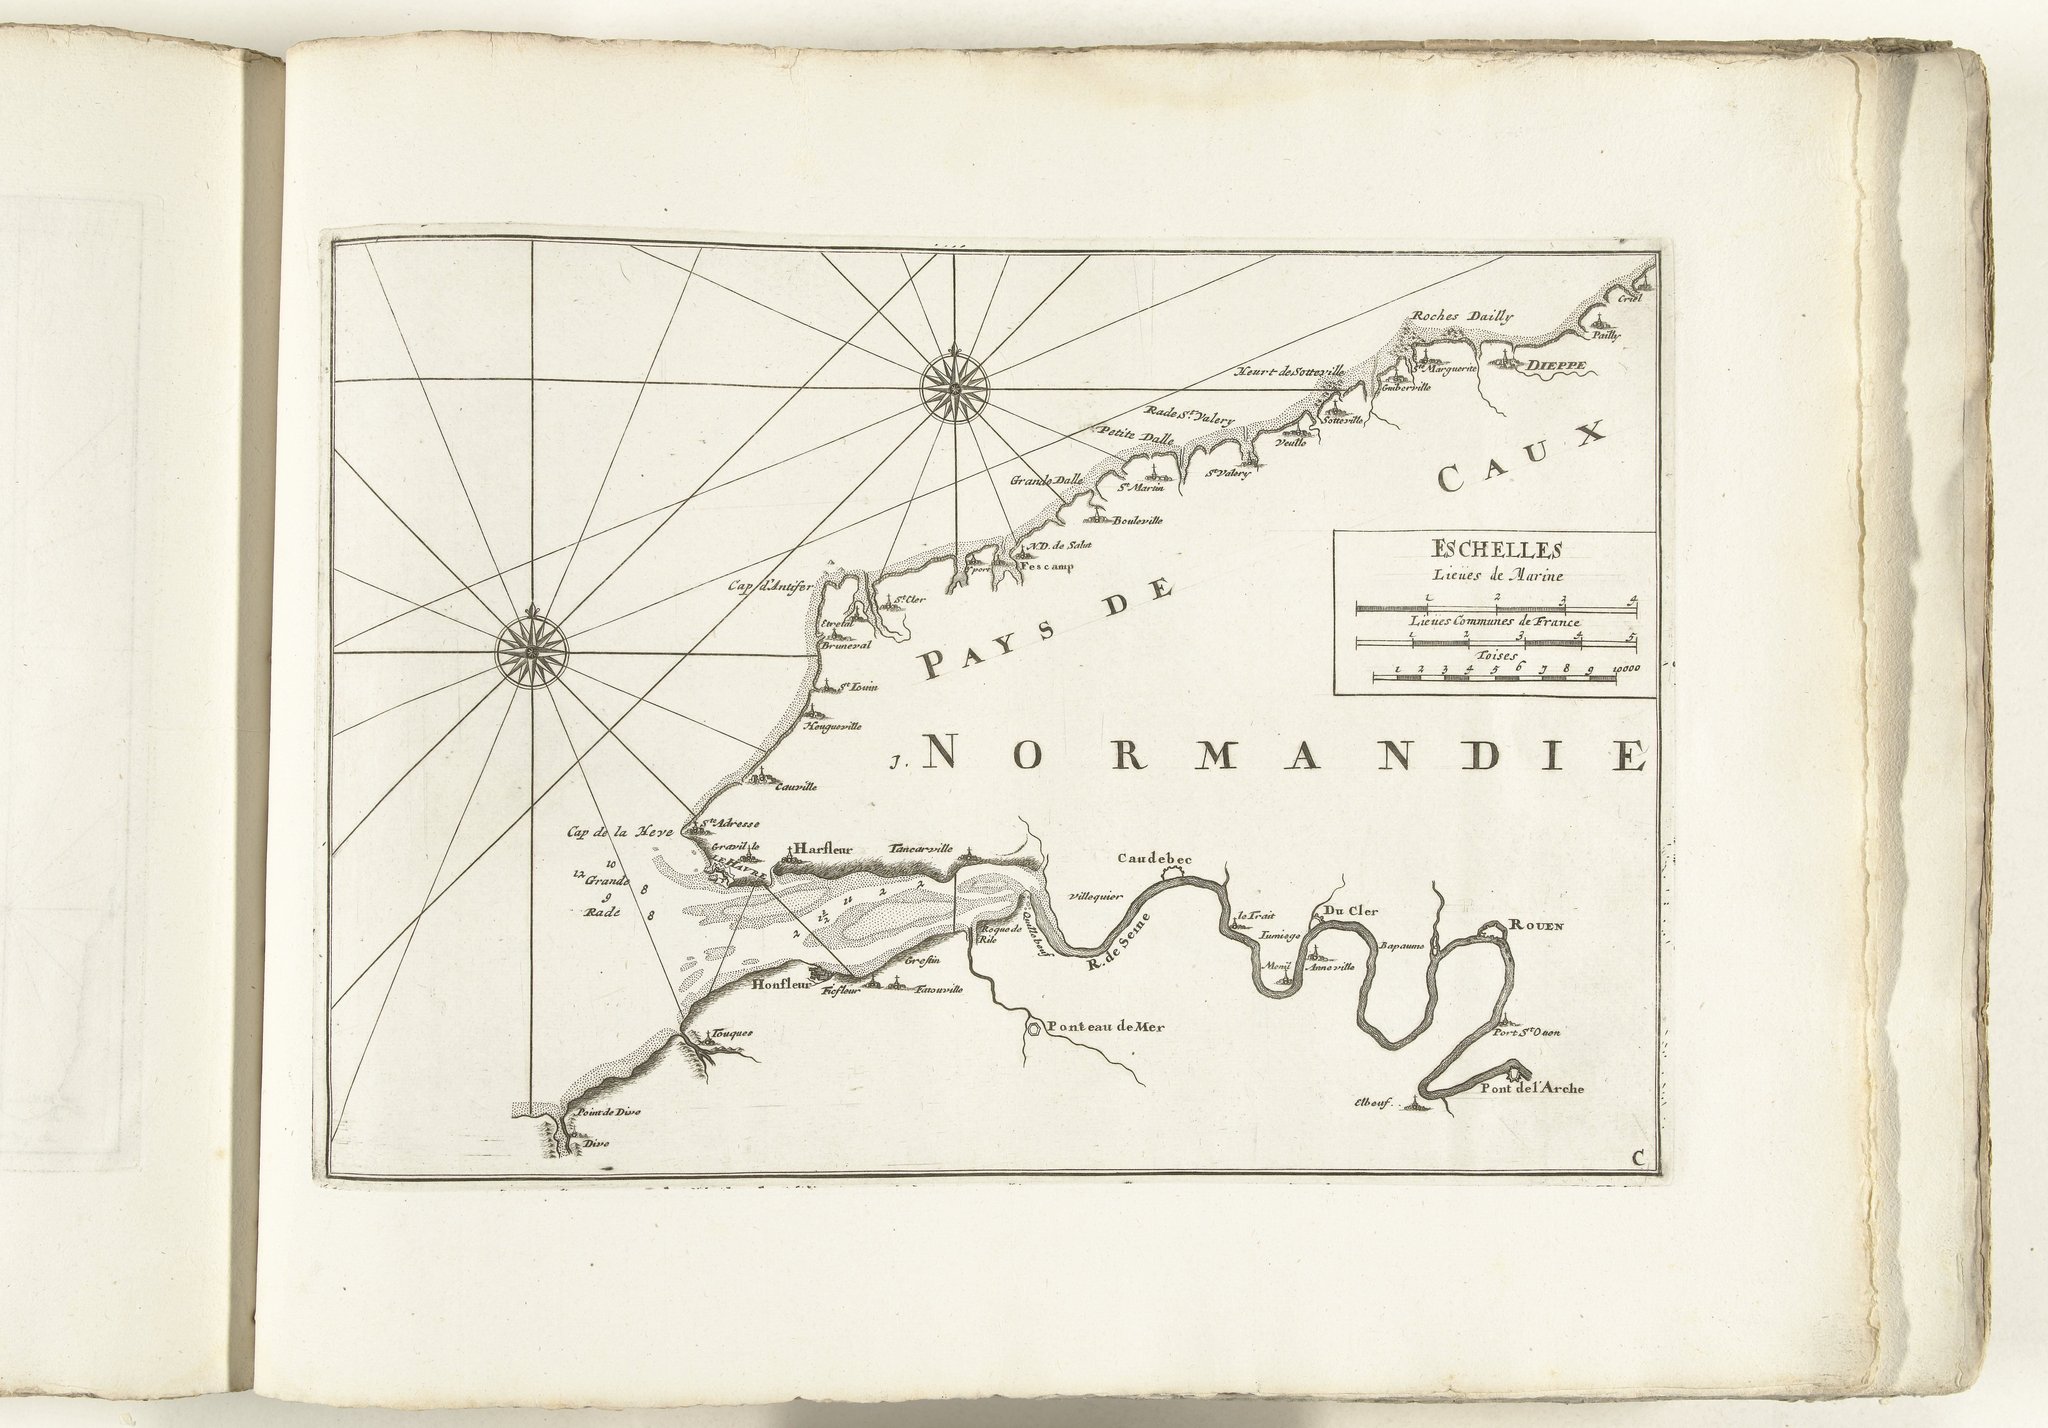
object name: print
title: Kaart van de Franse kust tussen Dieppe en Honfleur, ca. 1702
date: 1702-1703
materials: paper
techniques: etching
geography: amsterdam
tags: maps of separate countries or regions, france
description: Kaart van de Franse kust tussen Dieppe en Honfleur. Gemerkt rechtsonder: C. Onderdeel van het eerste van twee delen van het prentwerk: Les costes de France et d'Espagne (oftewel deel 13 van: Les Forces de l'Europe, Asie, Afrique et Amerique), uitgegeven ca. 1702. Het prentwerk bestaat in totaal uit 43 gemerkte platen van de kust van Frankrijk en Spanje, in het kader van de Spaanse Successieoorlog. Deze platen zijn gekopieerd naar anonieme Franse platen oorspronkelijk uitgegeven door Nicolas de Fer te Parijs. Titel en opschriften in de plaat in het Frans.